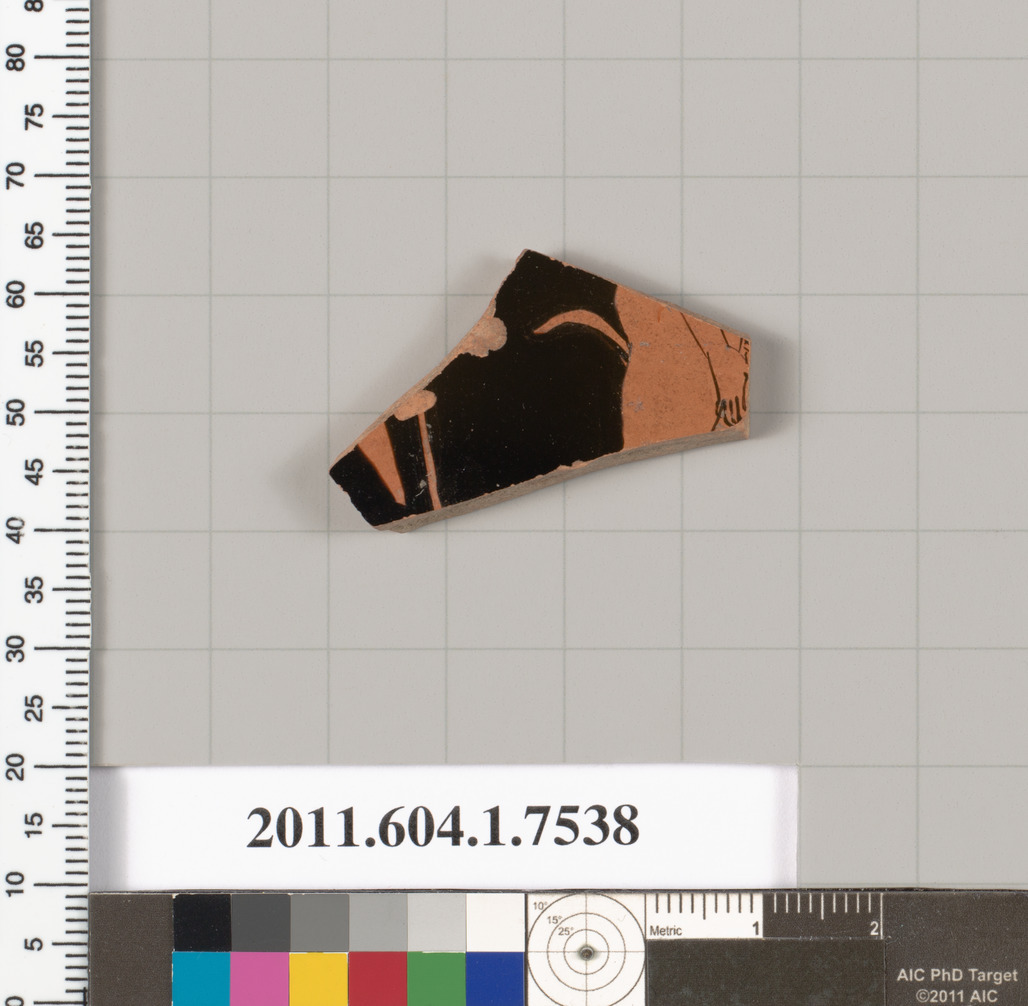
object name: kylix fragment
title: Terracotta fragment of a kylix (drinking cup)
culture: greek, attic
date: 460-450 BCE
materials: terracotta